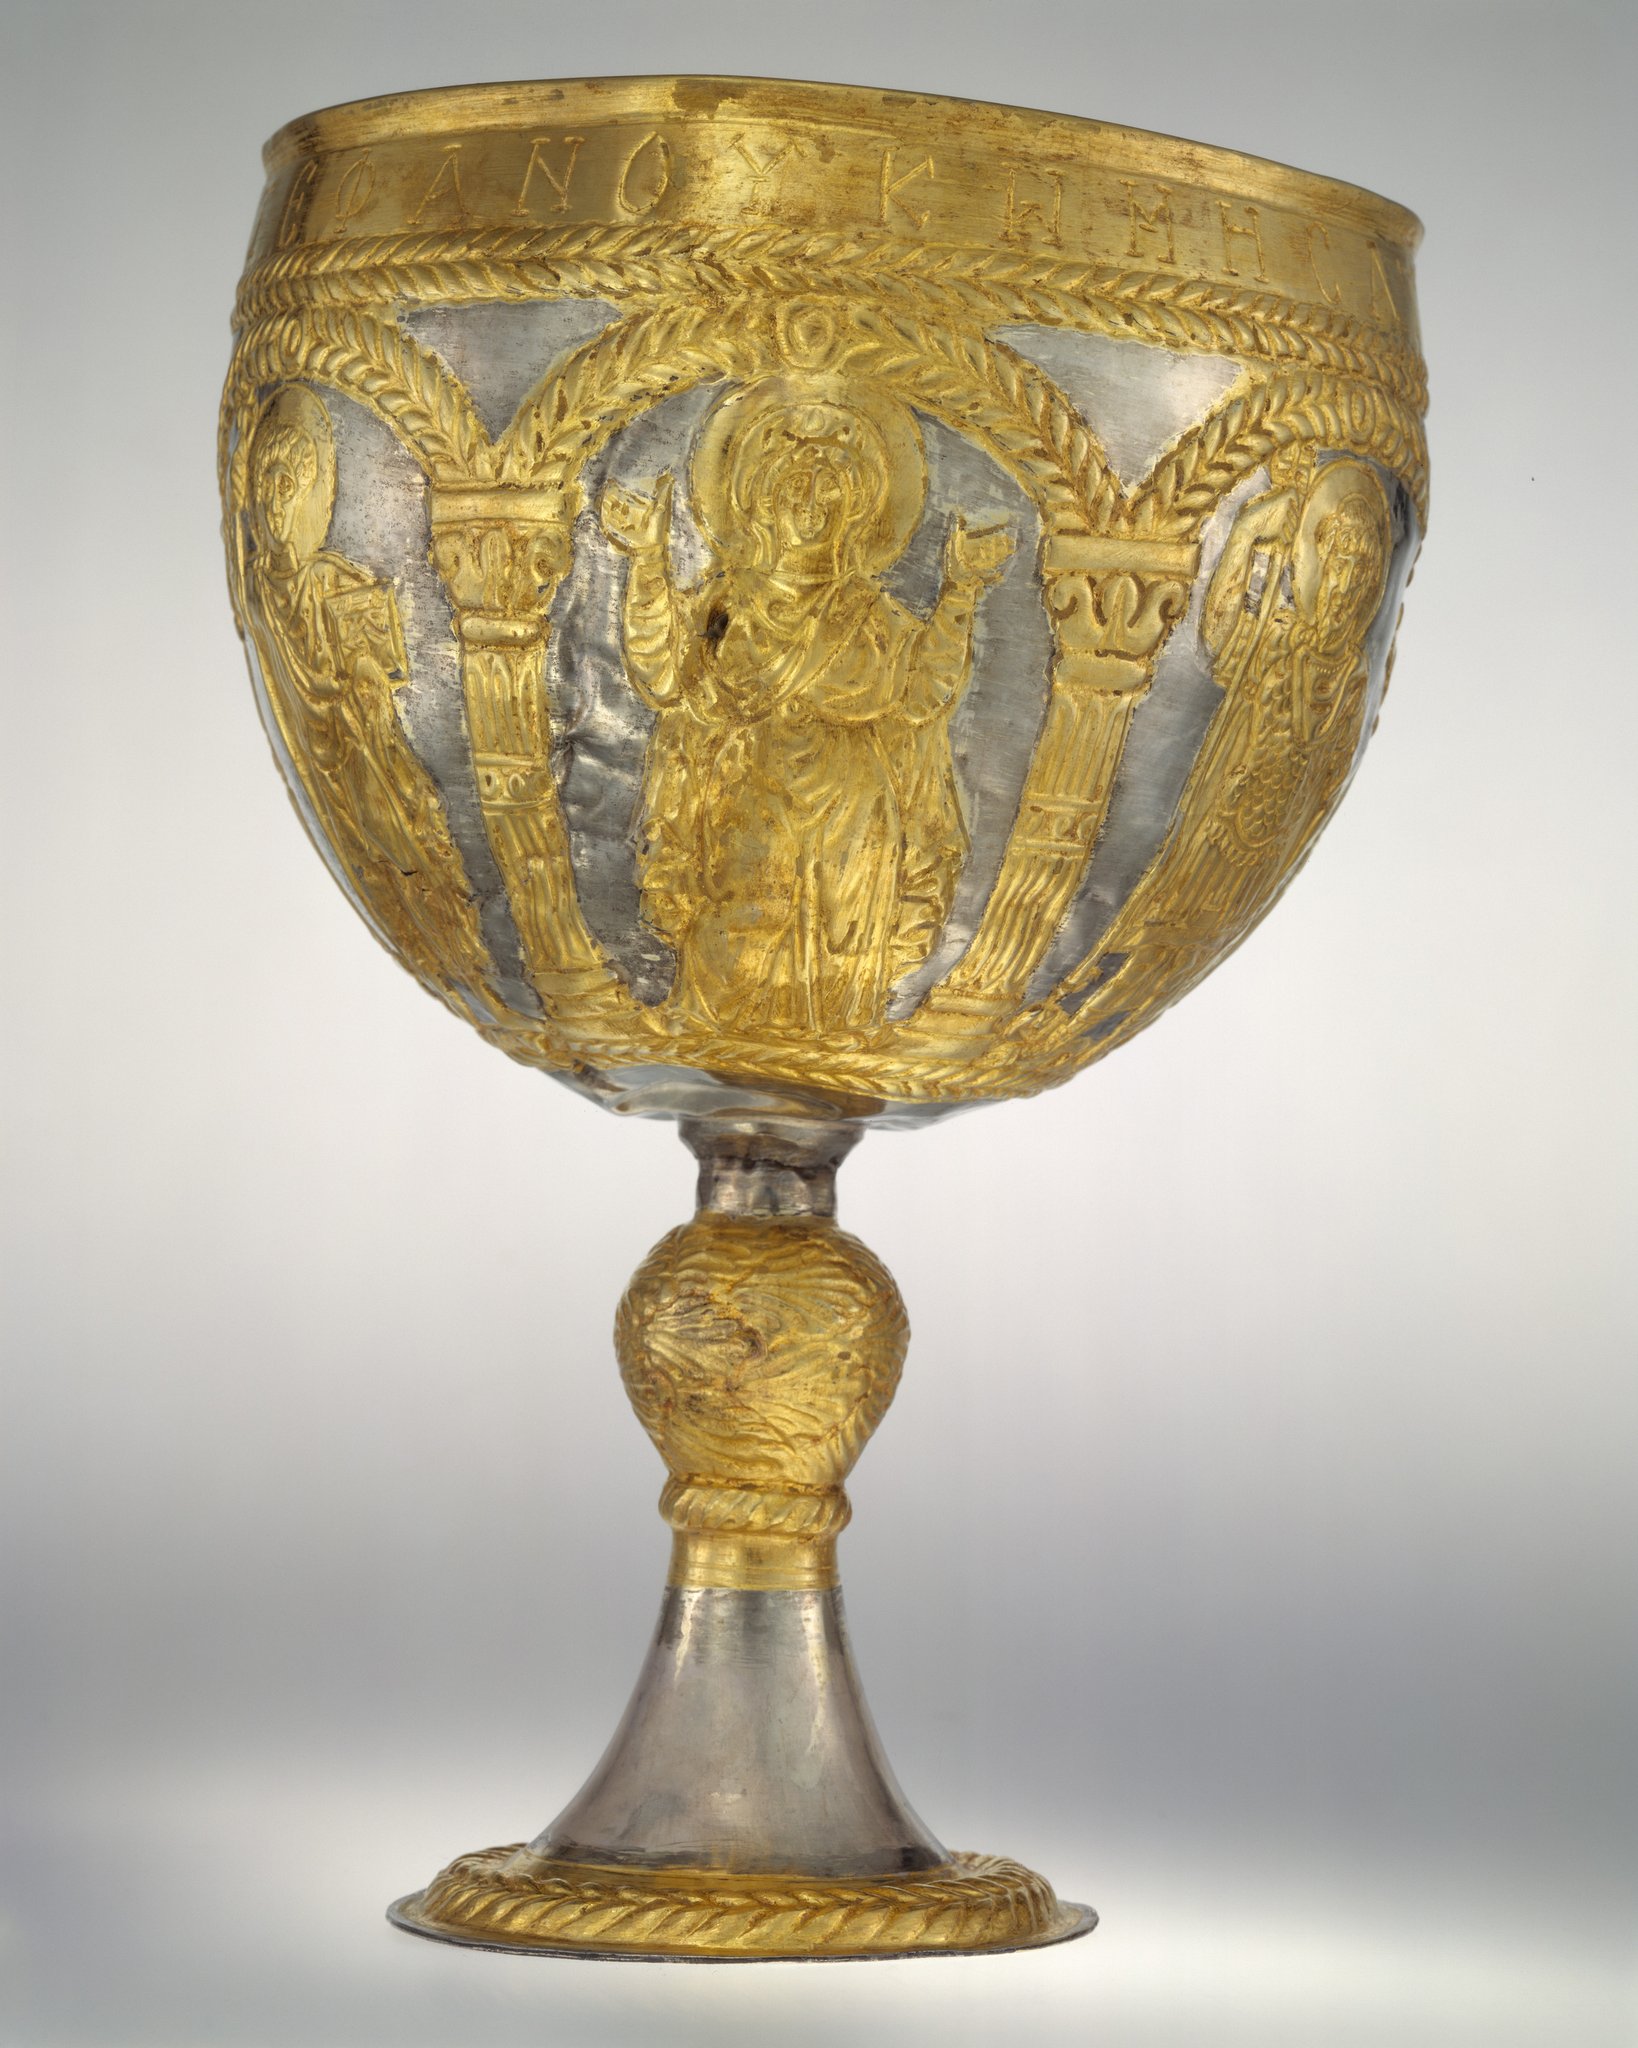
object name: chalice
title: The Attarouthi Treasure - Chalice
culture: byzantine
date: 500-650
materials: gilt silver, silver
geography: syria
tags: christ,virgin mary